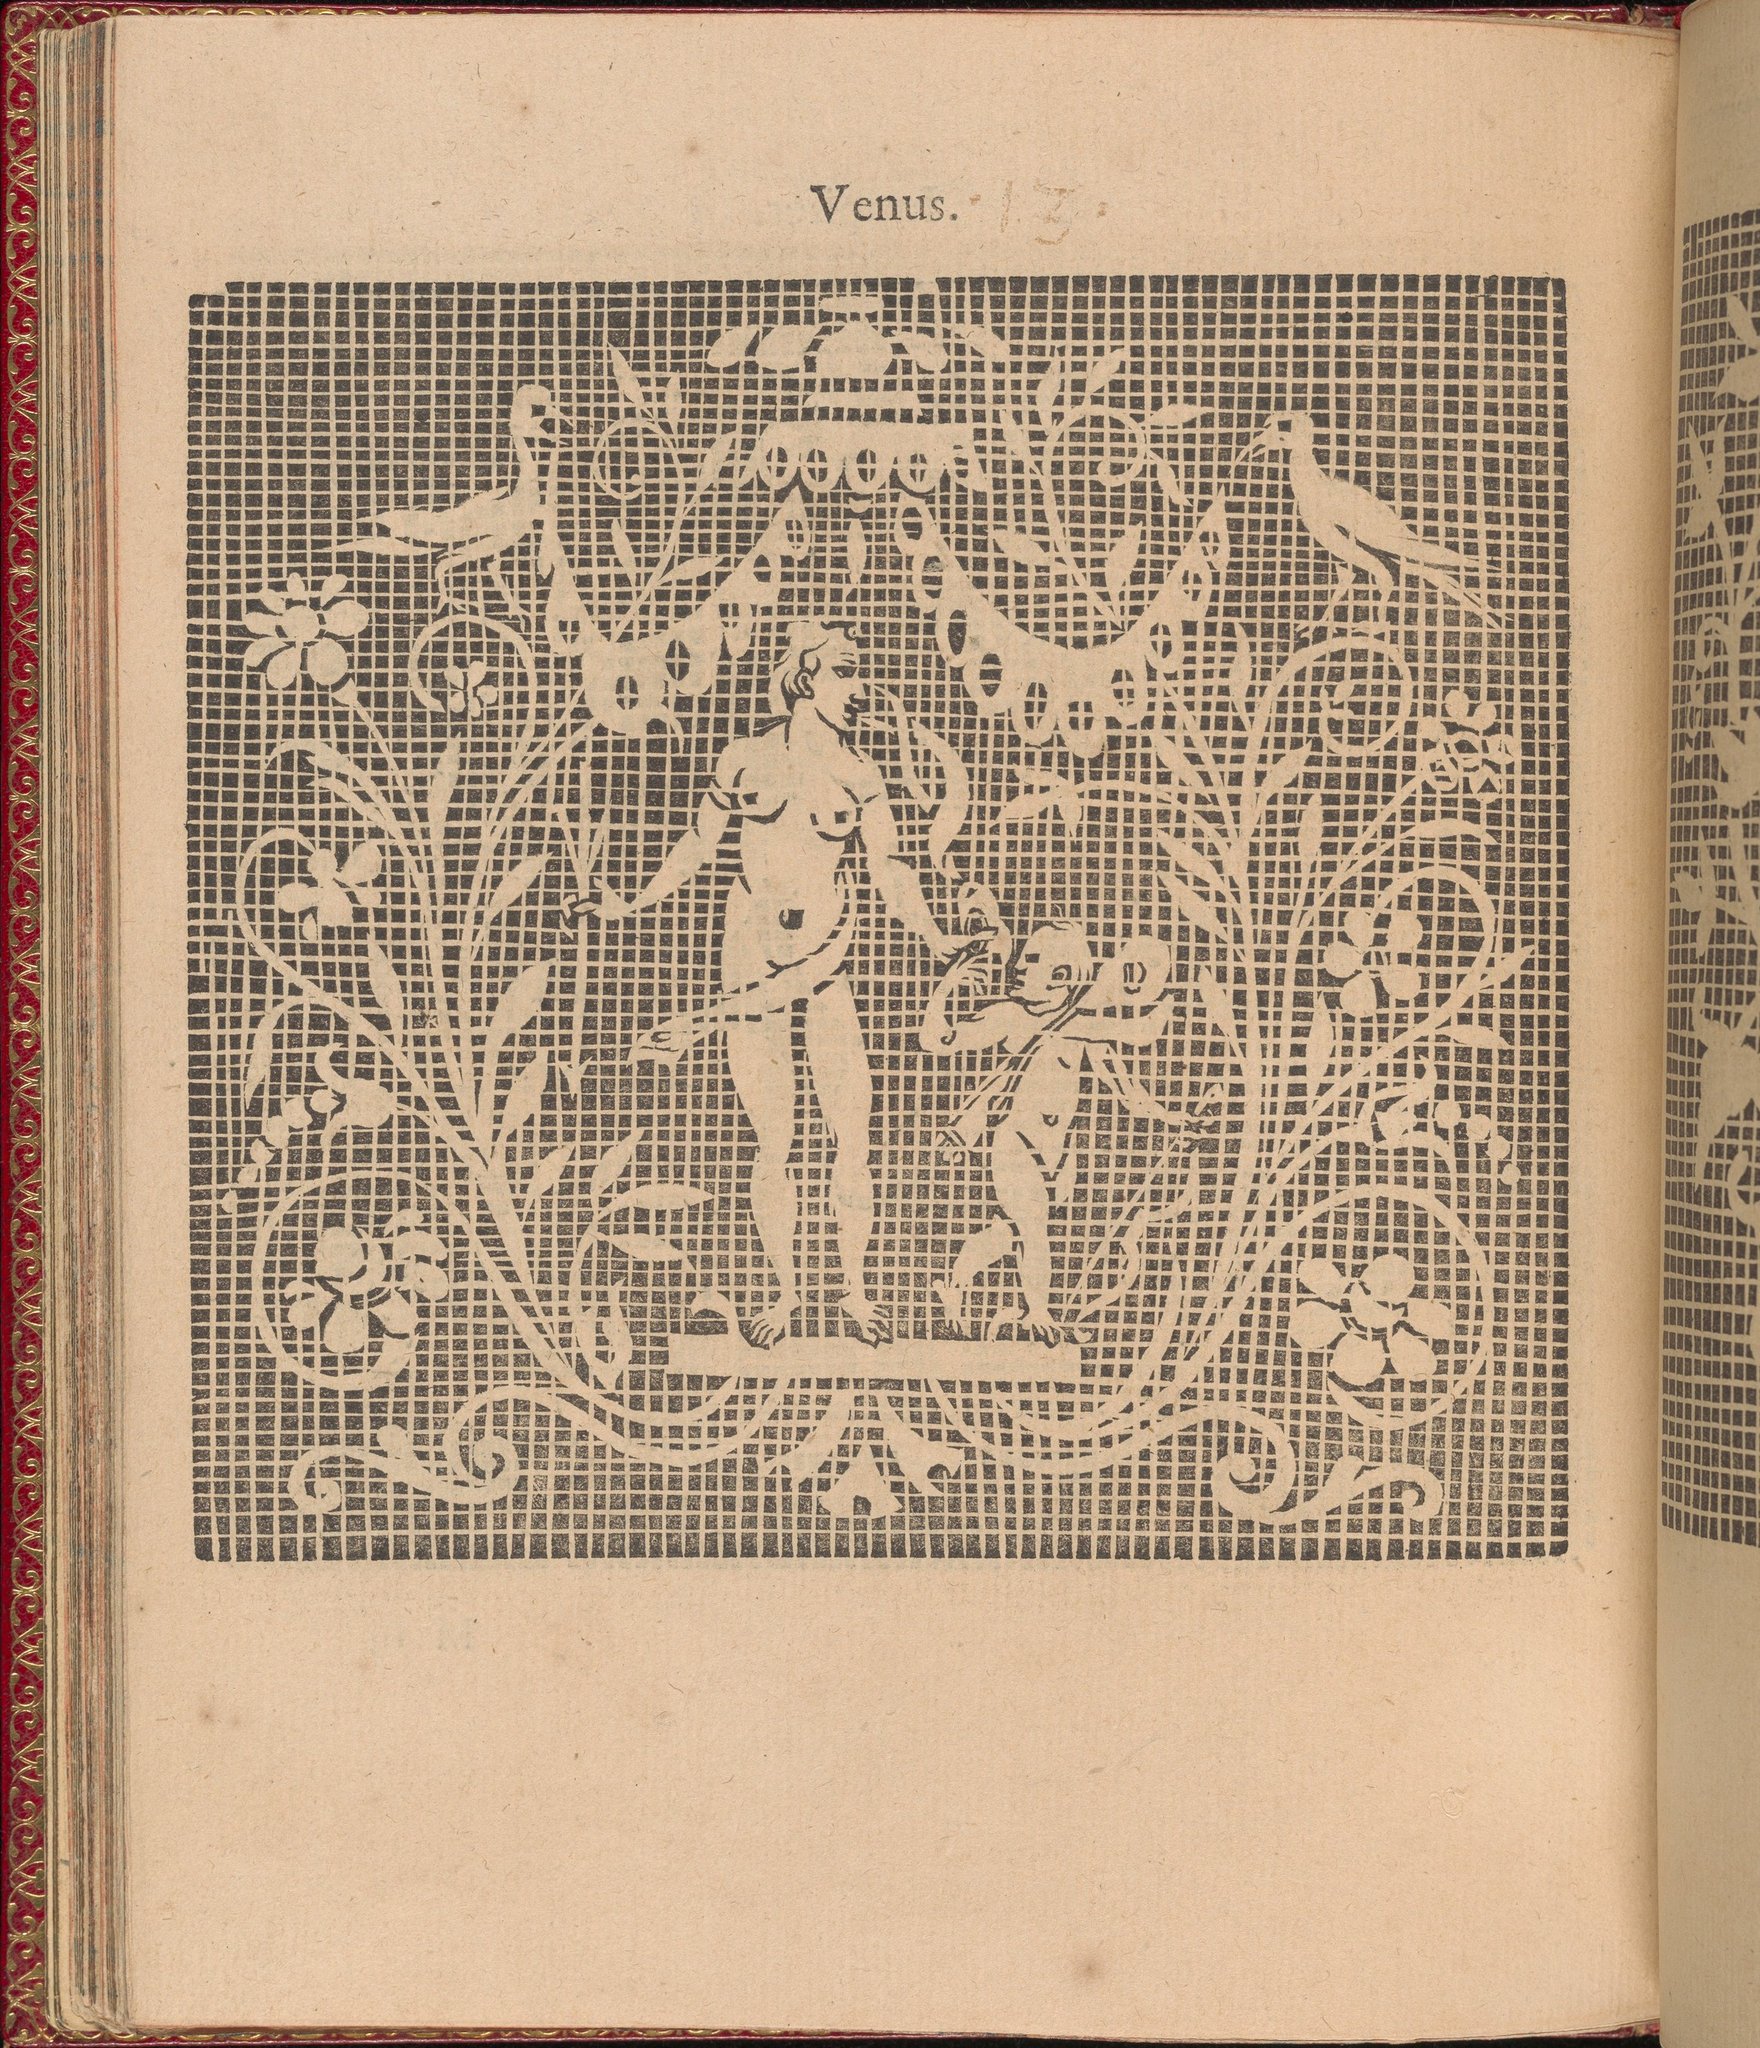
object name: book print ornament architecture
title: Les Singuliers et Nouveaux Portraicts... page 47 (verso)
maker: federico de vinciolo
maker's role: designer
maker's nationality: italian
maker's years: 1582-1599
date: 1588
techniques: woodcut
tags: birds,ornament,cupid,venus